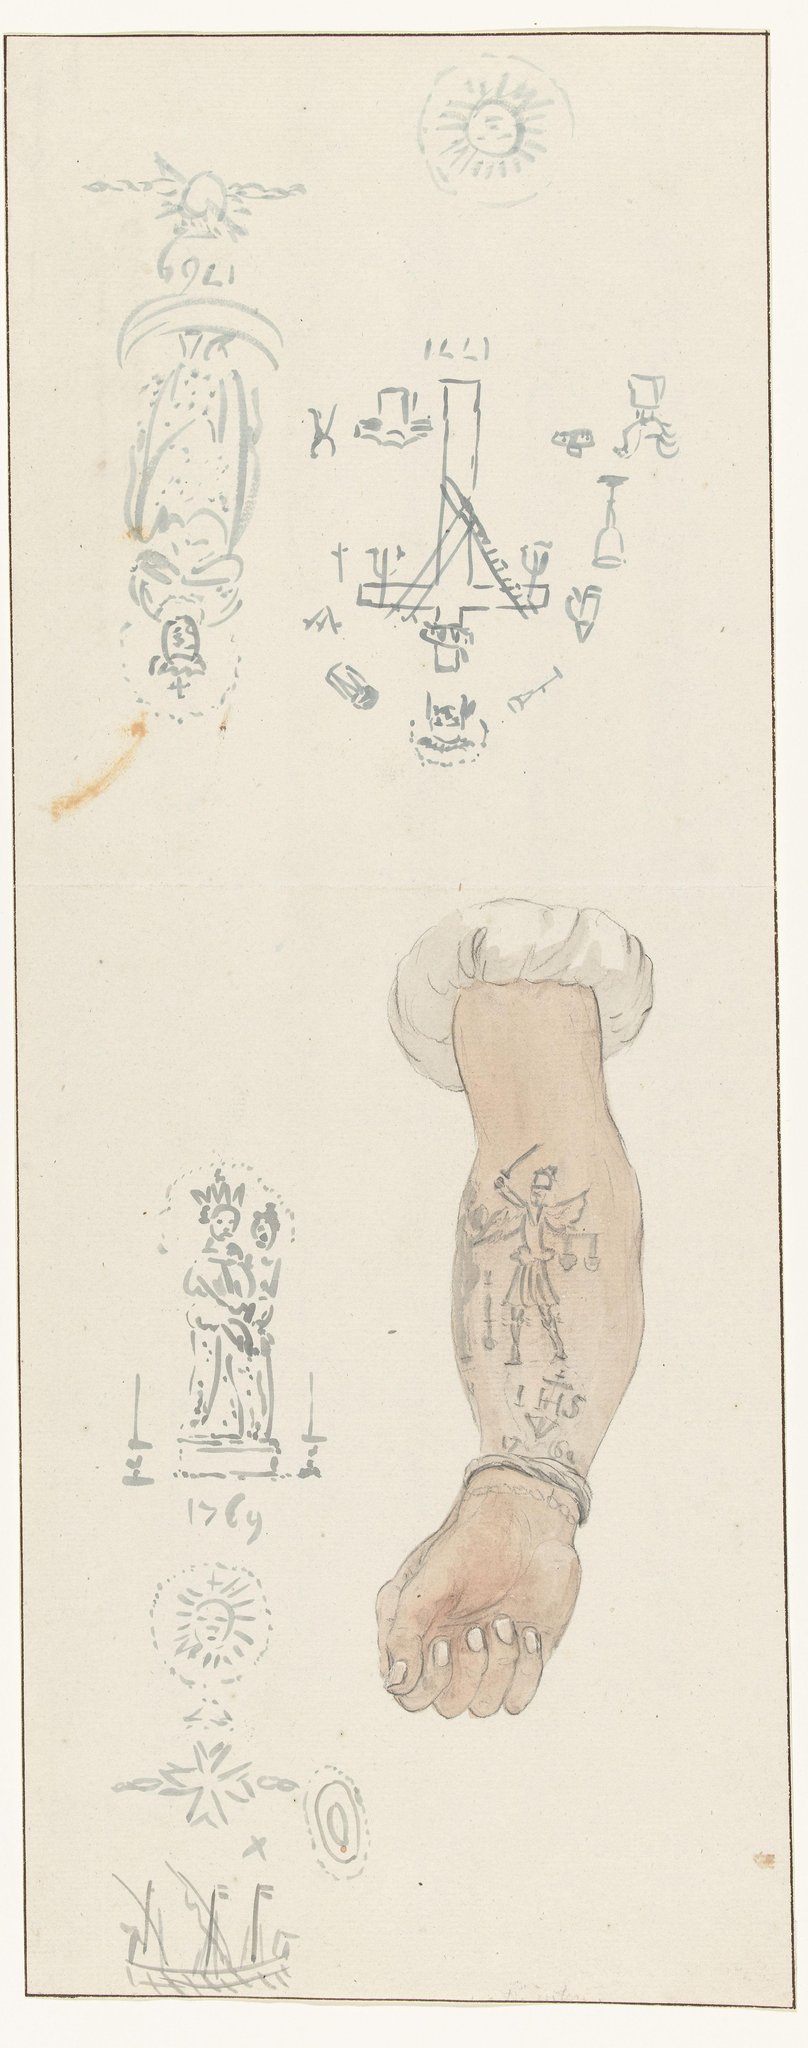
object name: watercolor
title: Figures imprimées sur les bras de nos matelots Tarentins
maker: louis ducros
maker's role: draughtsman, print maker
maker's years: 1748-1810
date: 1778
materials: chalk, paper, watercolor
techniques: brush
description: Tekening uit het album 'Voyage en Italie, en Sicile et à Malte', 1778.